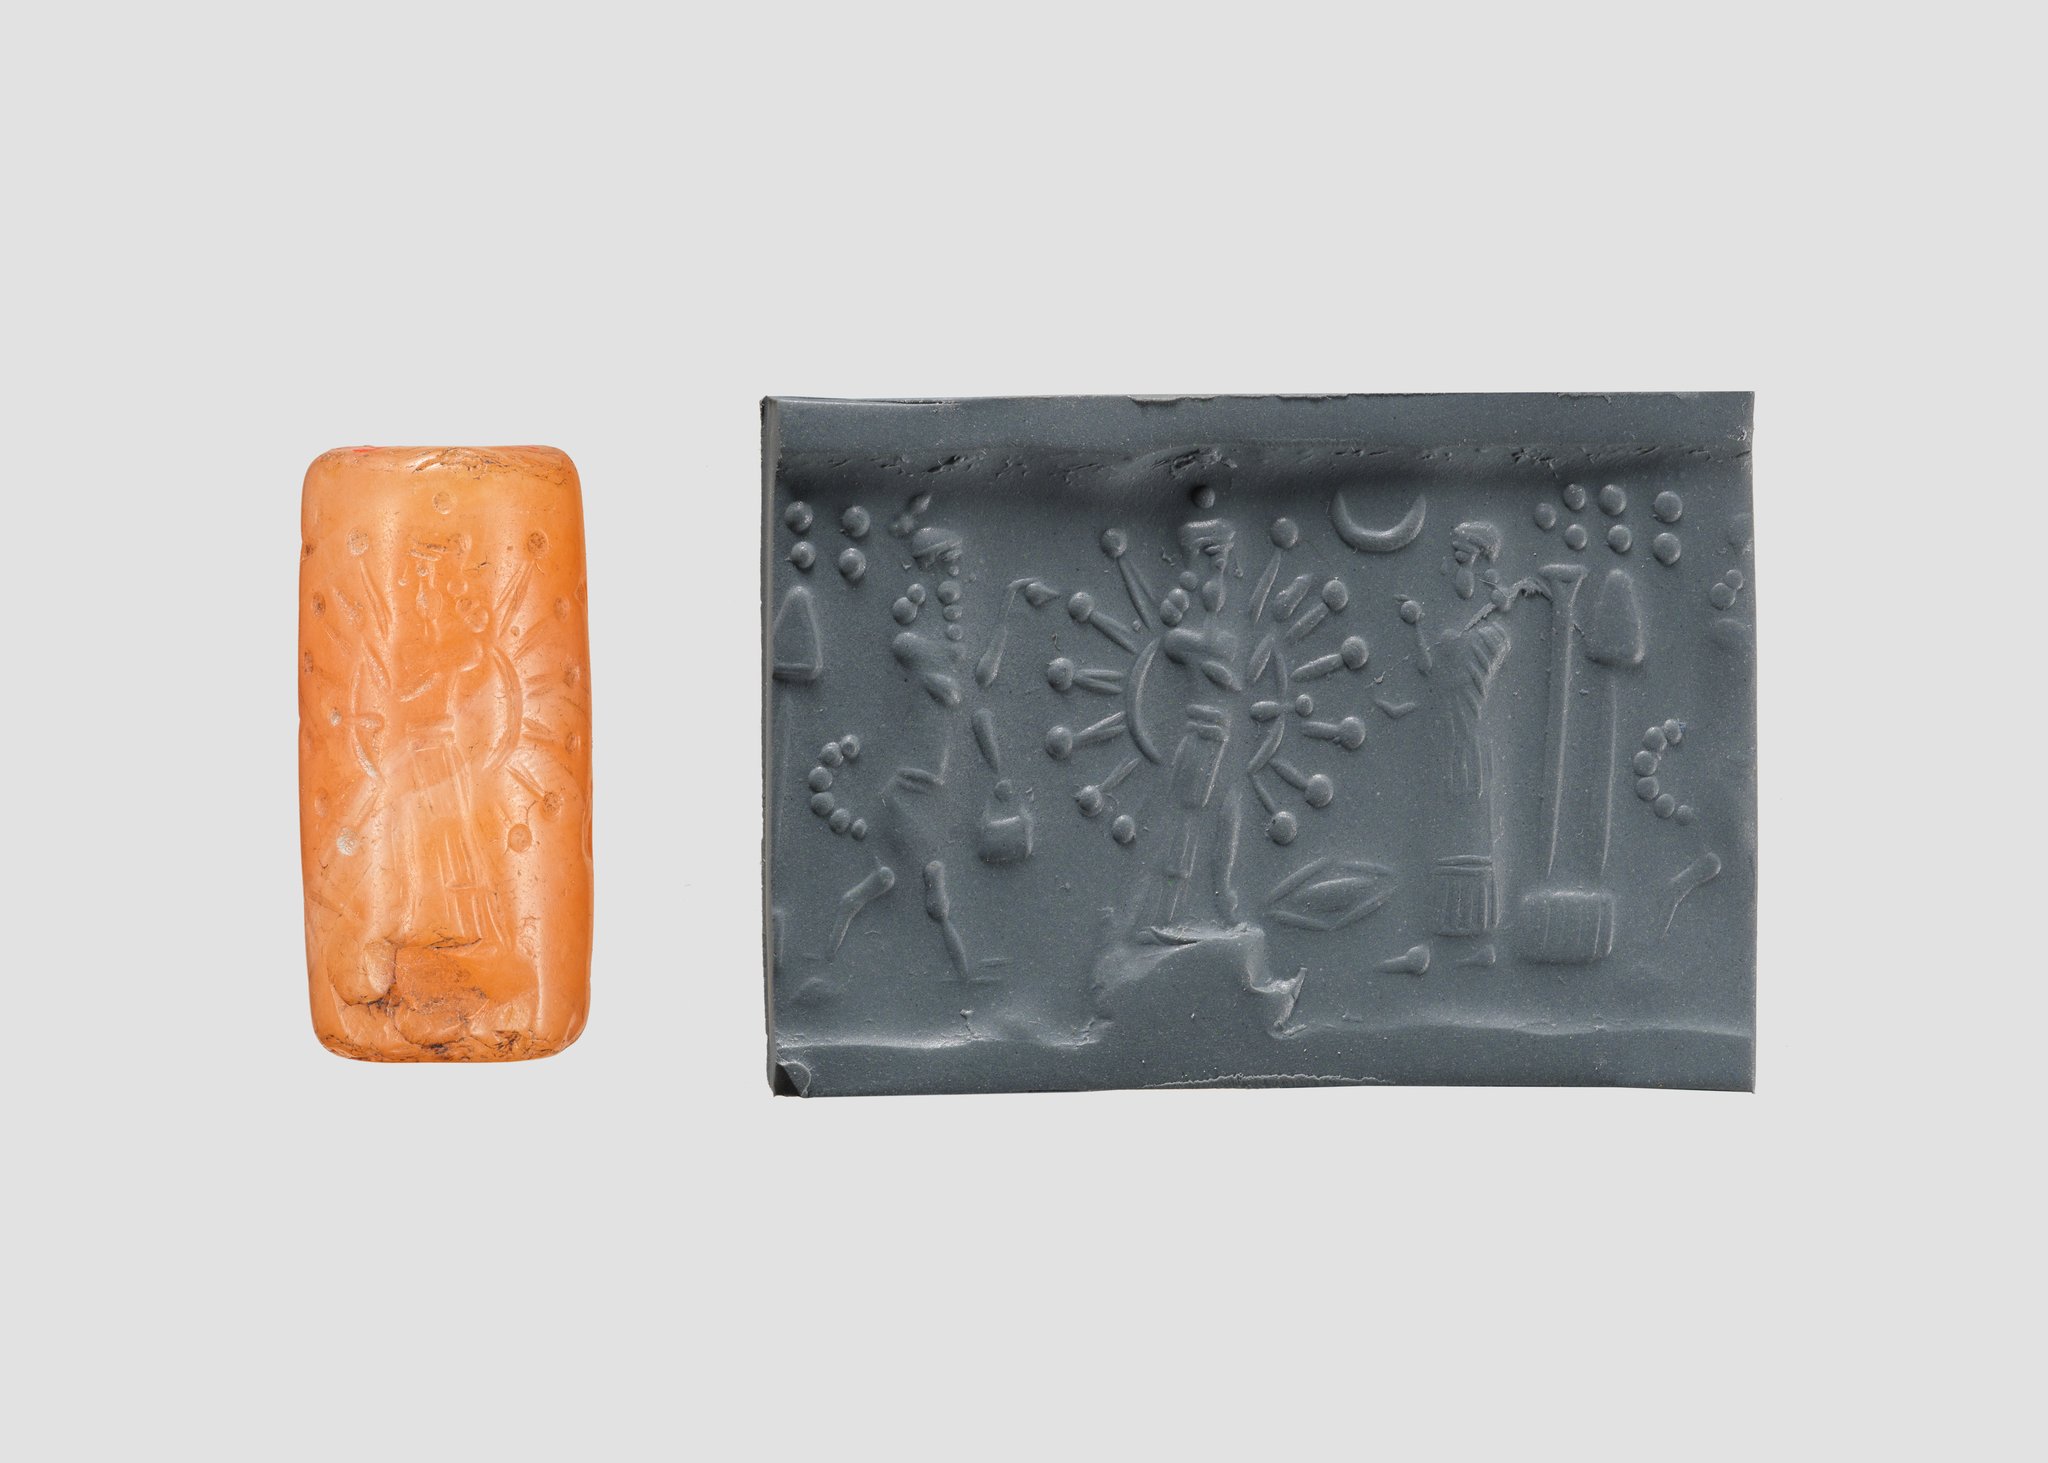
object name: cylinder seal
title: Cylinder seal with cultic scene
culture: assyrian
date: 800-601 BCE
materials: gemstone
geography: mesopotamia